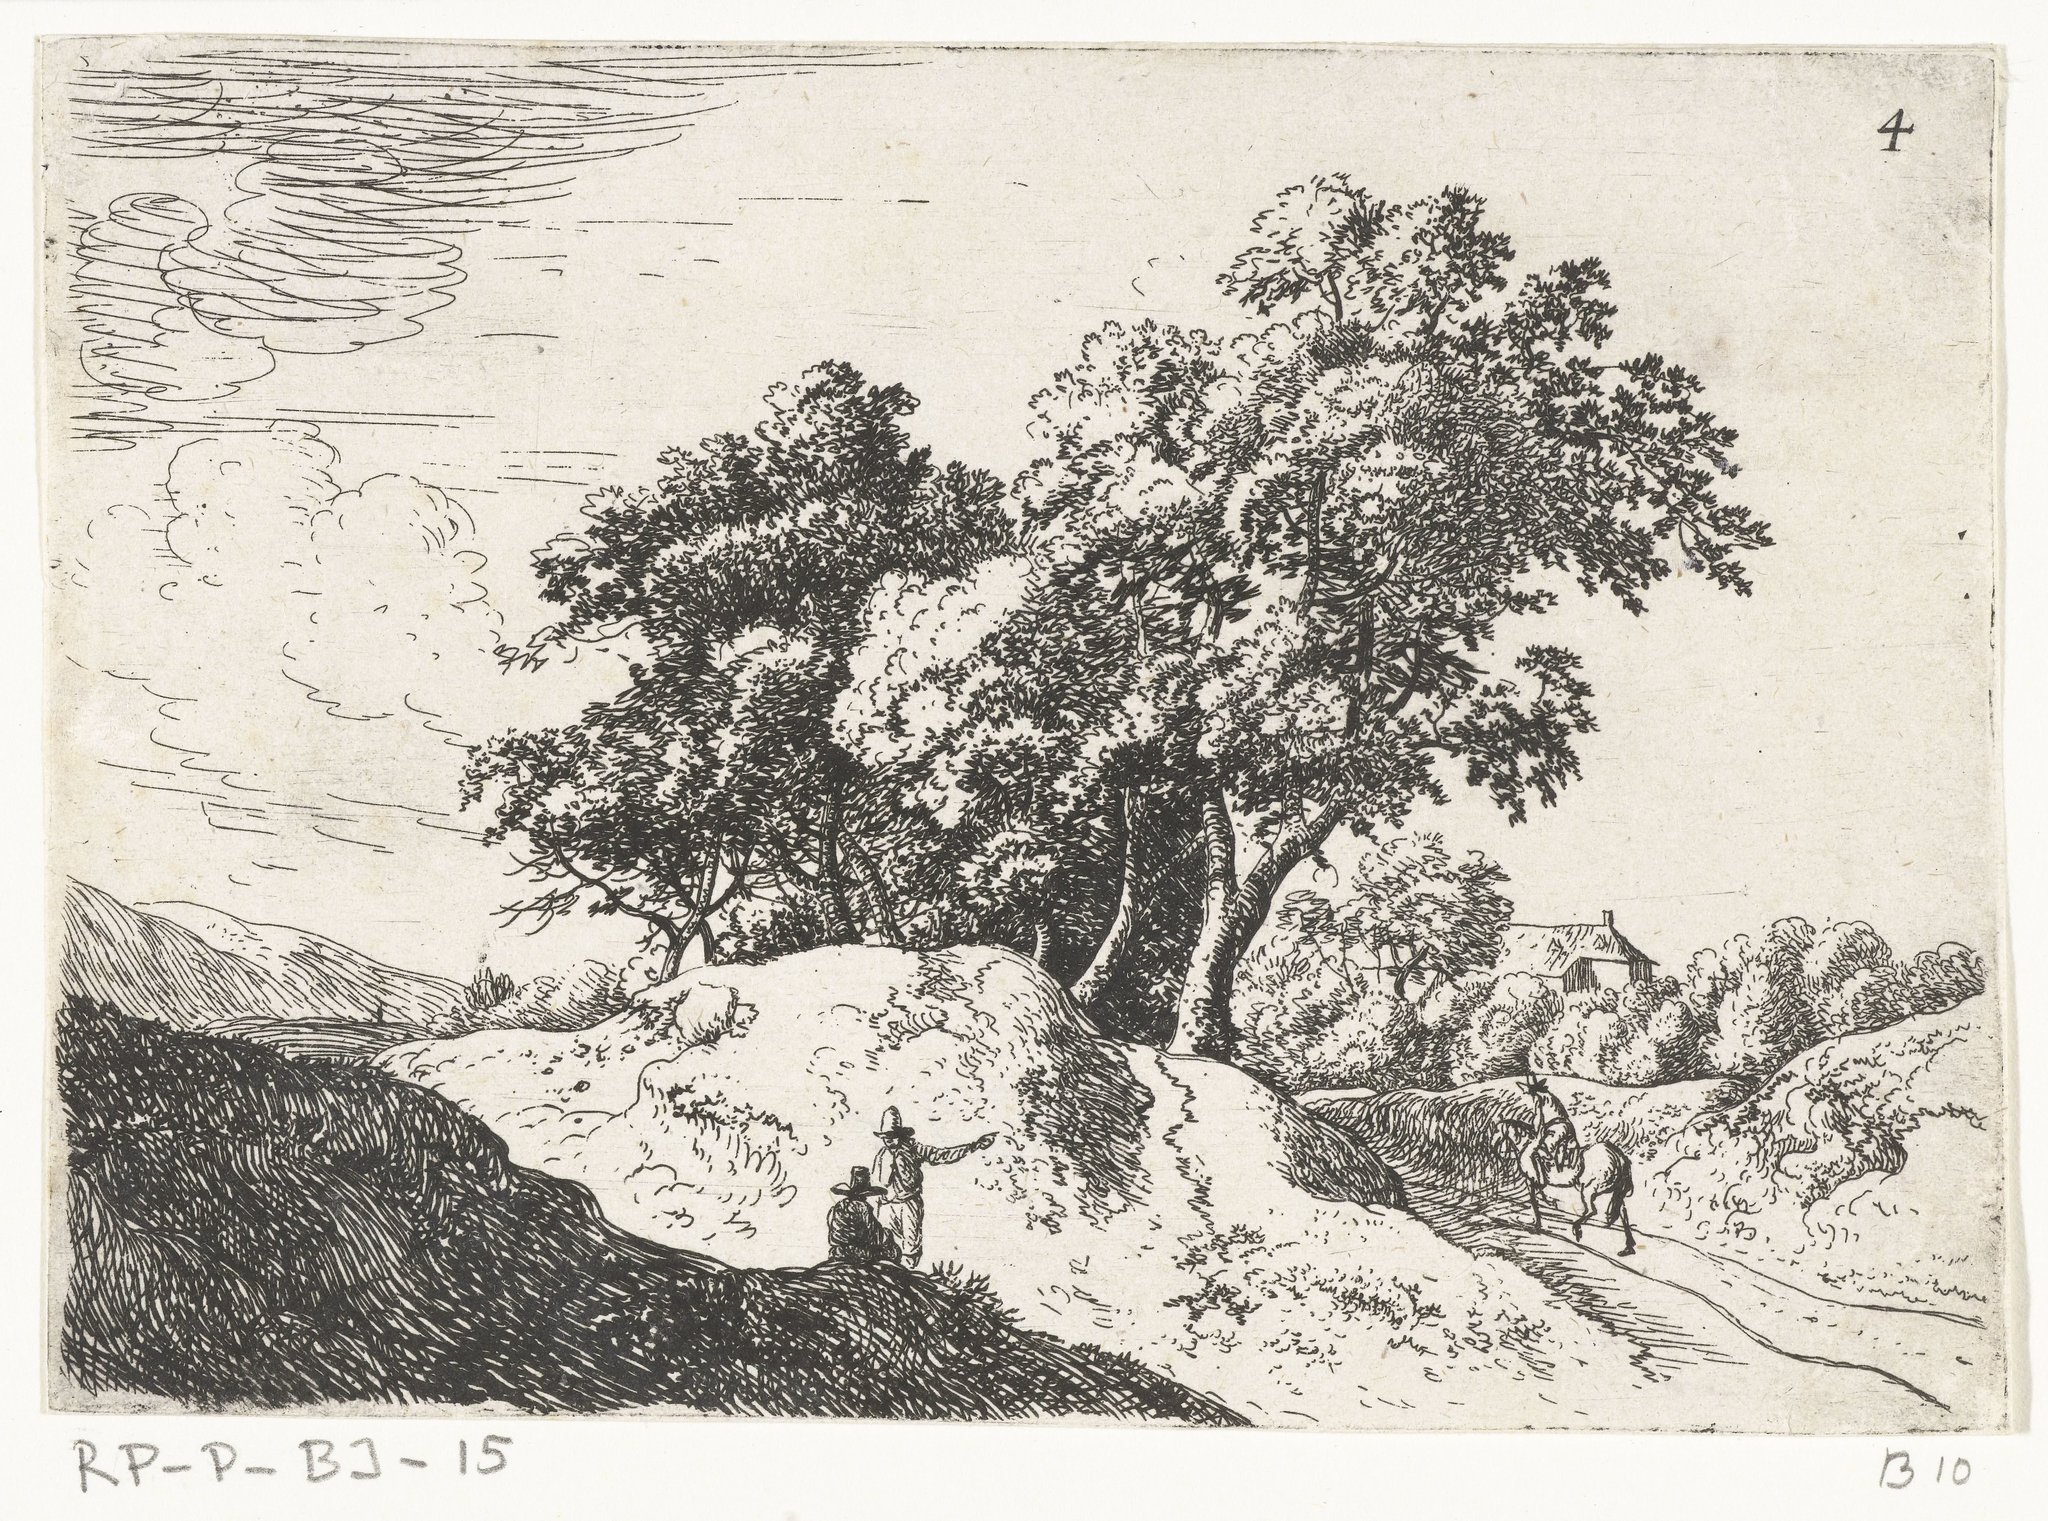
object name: print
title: Groep bomen op een heuvel met passerende ruiter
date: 1624-1661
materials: paper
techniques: etching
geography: amsterdam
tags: landscapes in the temperate zone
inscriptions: collector's mark: Lugt 240